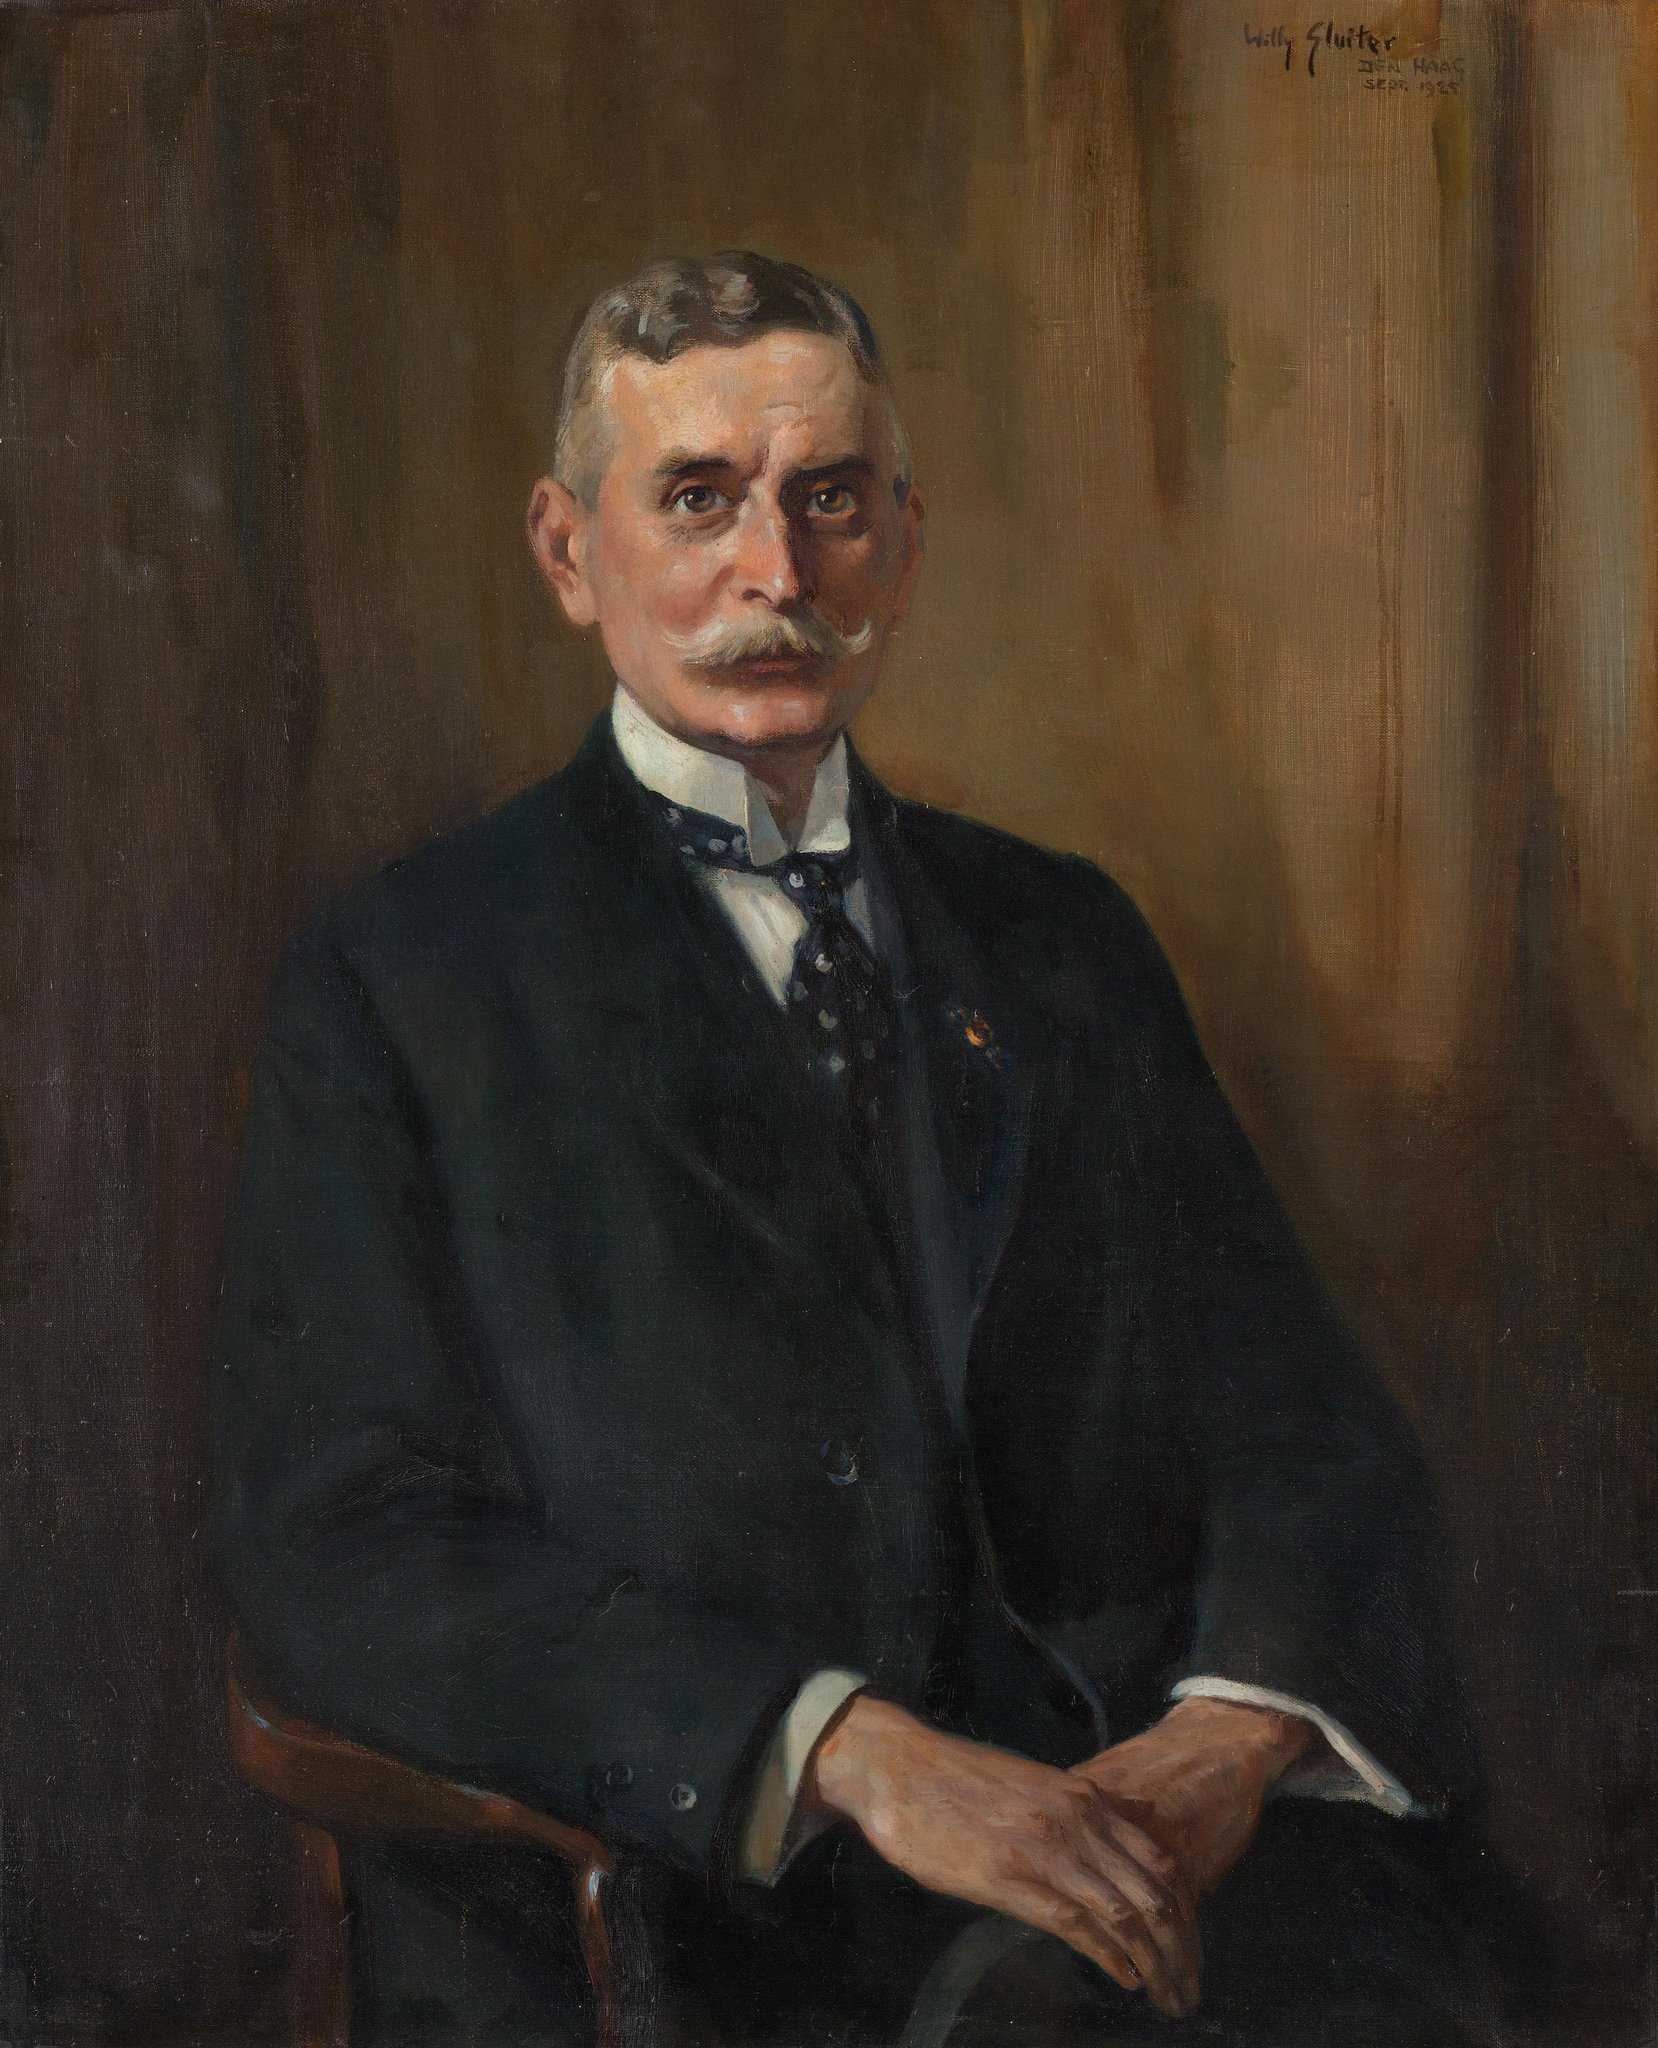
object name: painting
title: Jacob Christiaan Koningsberger (1867-1951). Chairman of the People's Council (1918-19)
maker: willy sluiter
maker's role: draughtsman, painter, print maker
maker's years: 1873-1949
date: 1909-1925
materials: canvas, oil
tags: historical persons, batavia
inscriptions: signature and date: ‘Willy Sluiter Den Haag Sept. 1925’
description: Portret van Jacob Christiaan Koningsberger (1867-1951). Voorzitter van de volksraad (1918-19). Ten halven lijve, zittend in een stoel, naar rechts, de handen in de schoot. Onderdeel van een groep portretten van de voorzitters van de volksraad van Nederlands Oost-Indië, behorend bij de reeks van portretten van de gouverneurs-generaal van het voormalige Nederlands Oost-Indië.